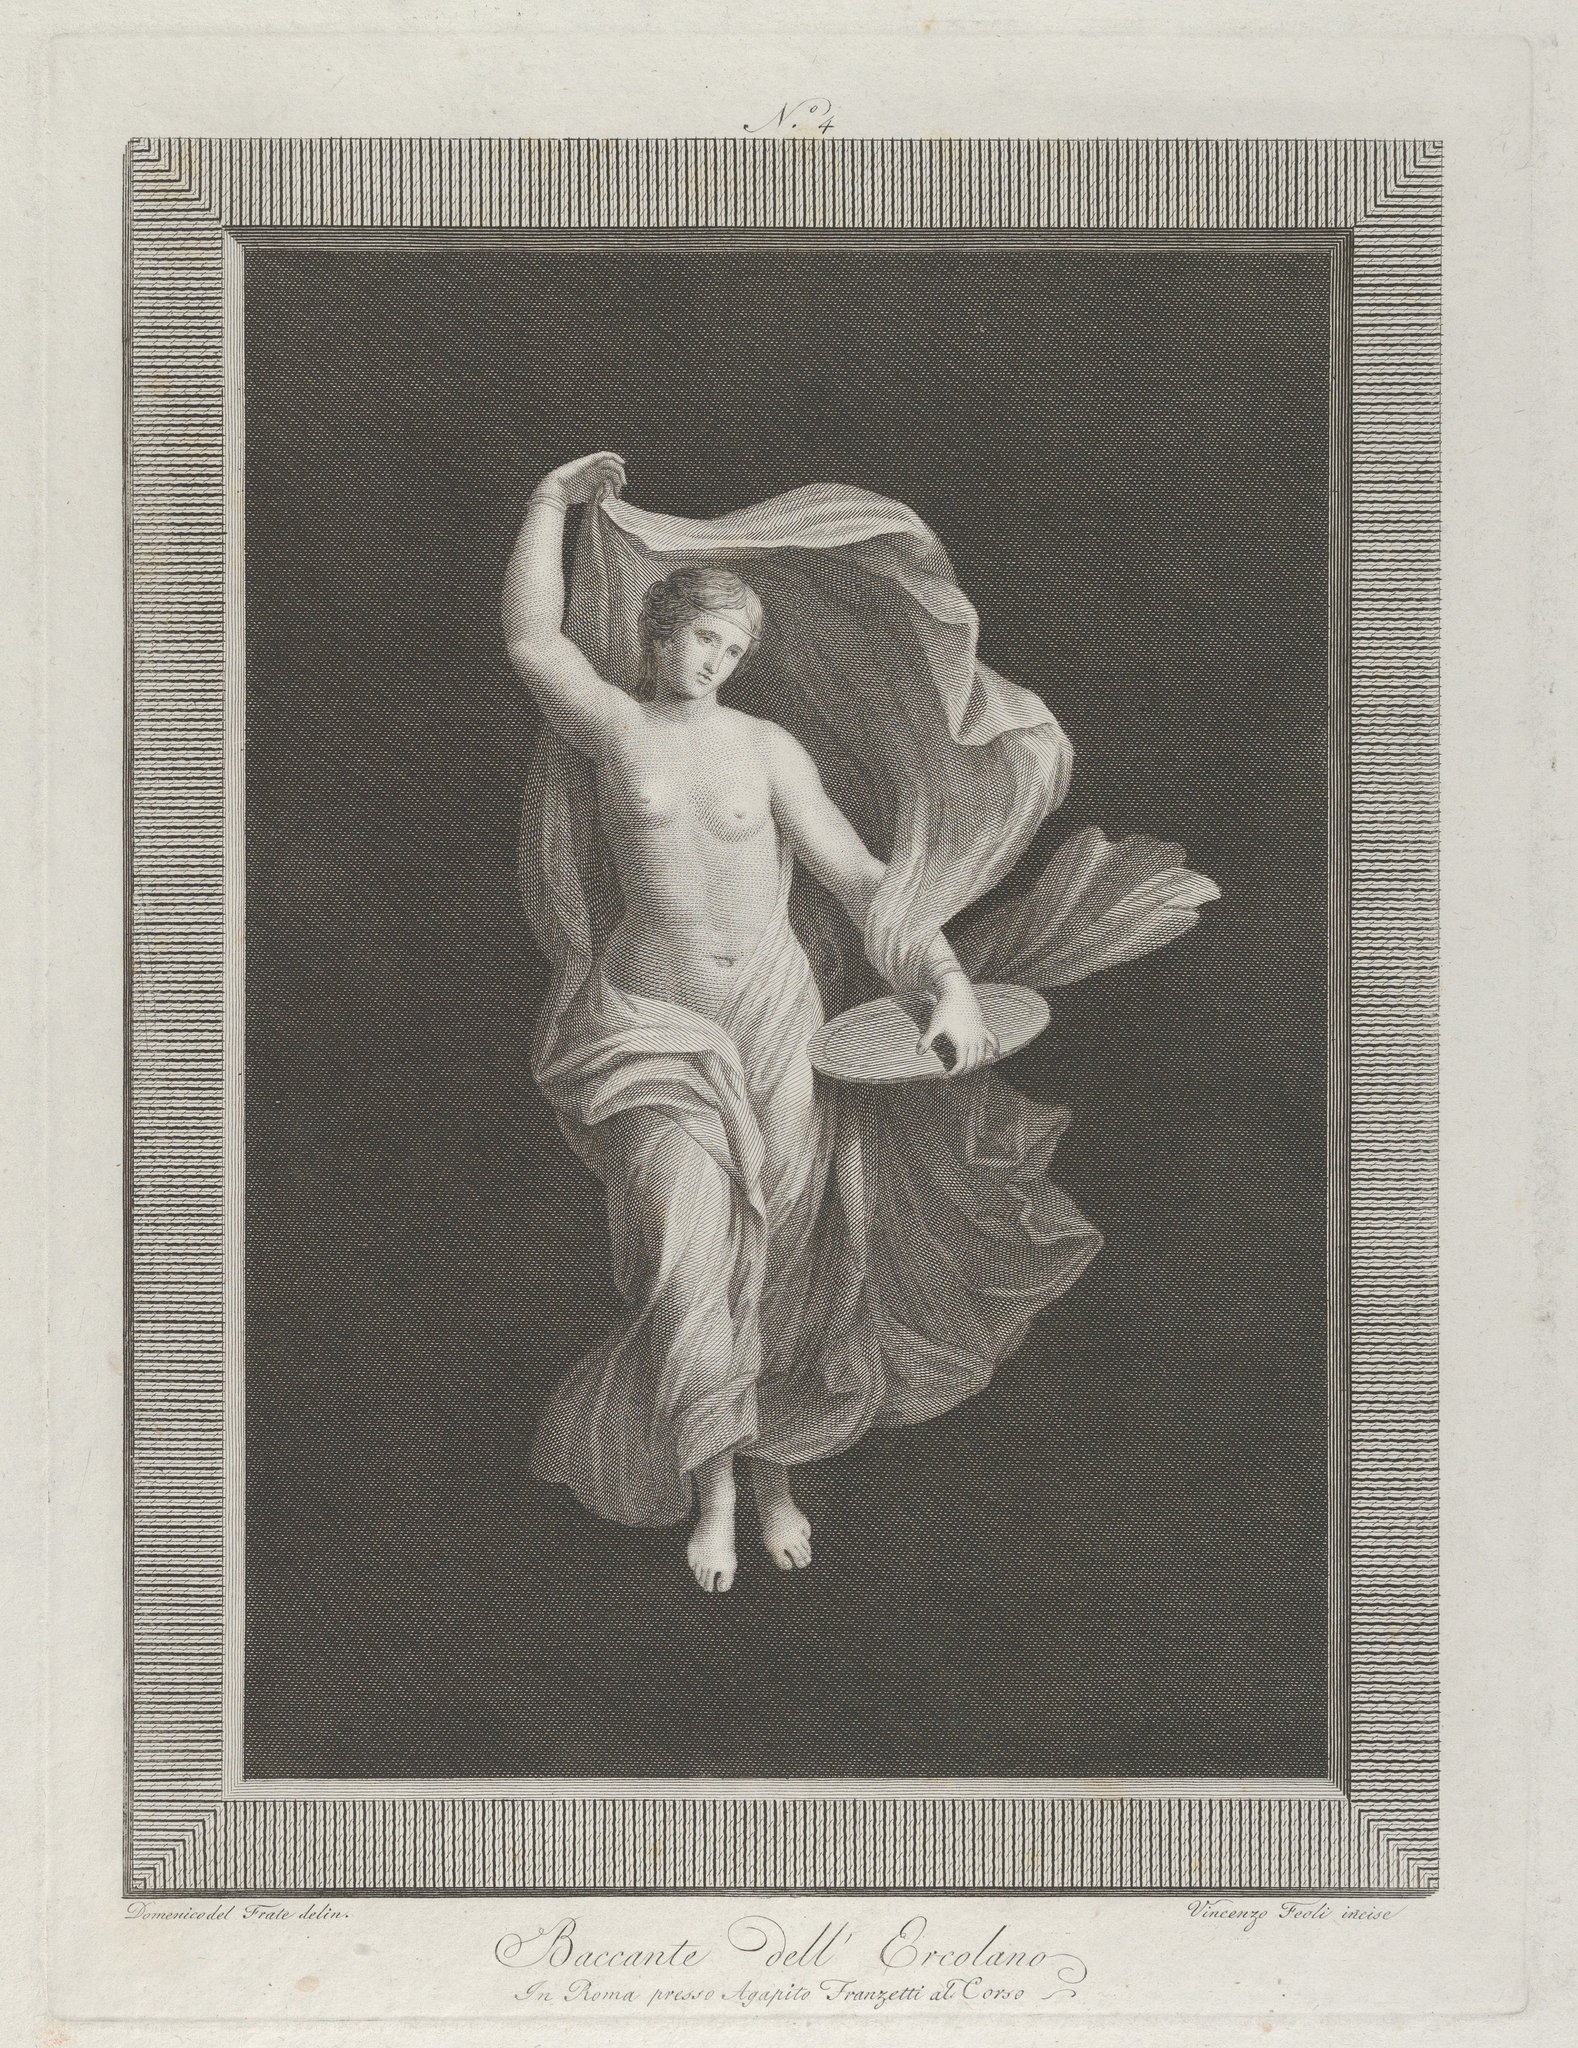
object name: print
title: A partly nude bacchante holding a disk in her left hand and raising her garments with right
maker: vicenzo feoli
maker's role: artist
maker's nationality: italian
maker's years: 1755-1827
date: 1795-1820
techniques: engraving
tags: bacchantes